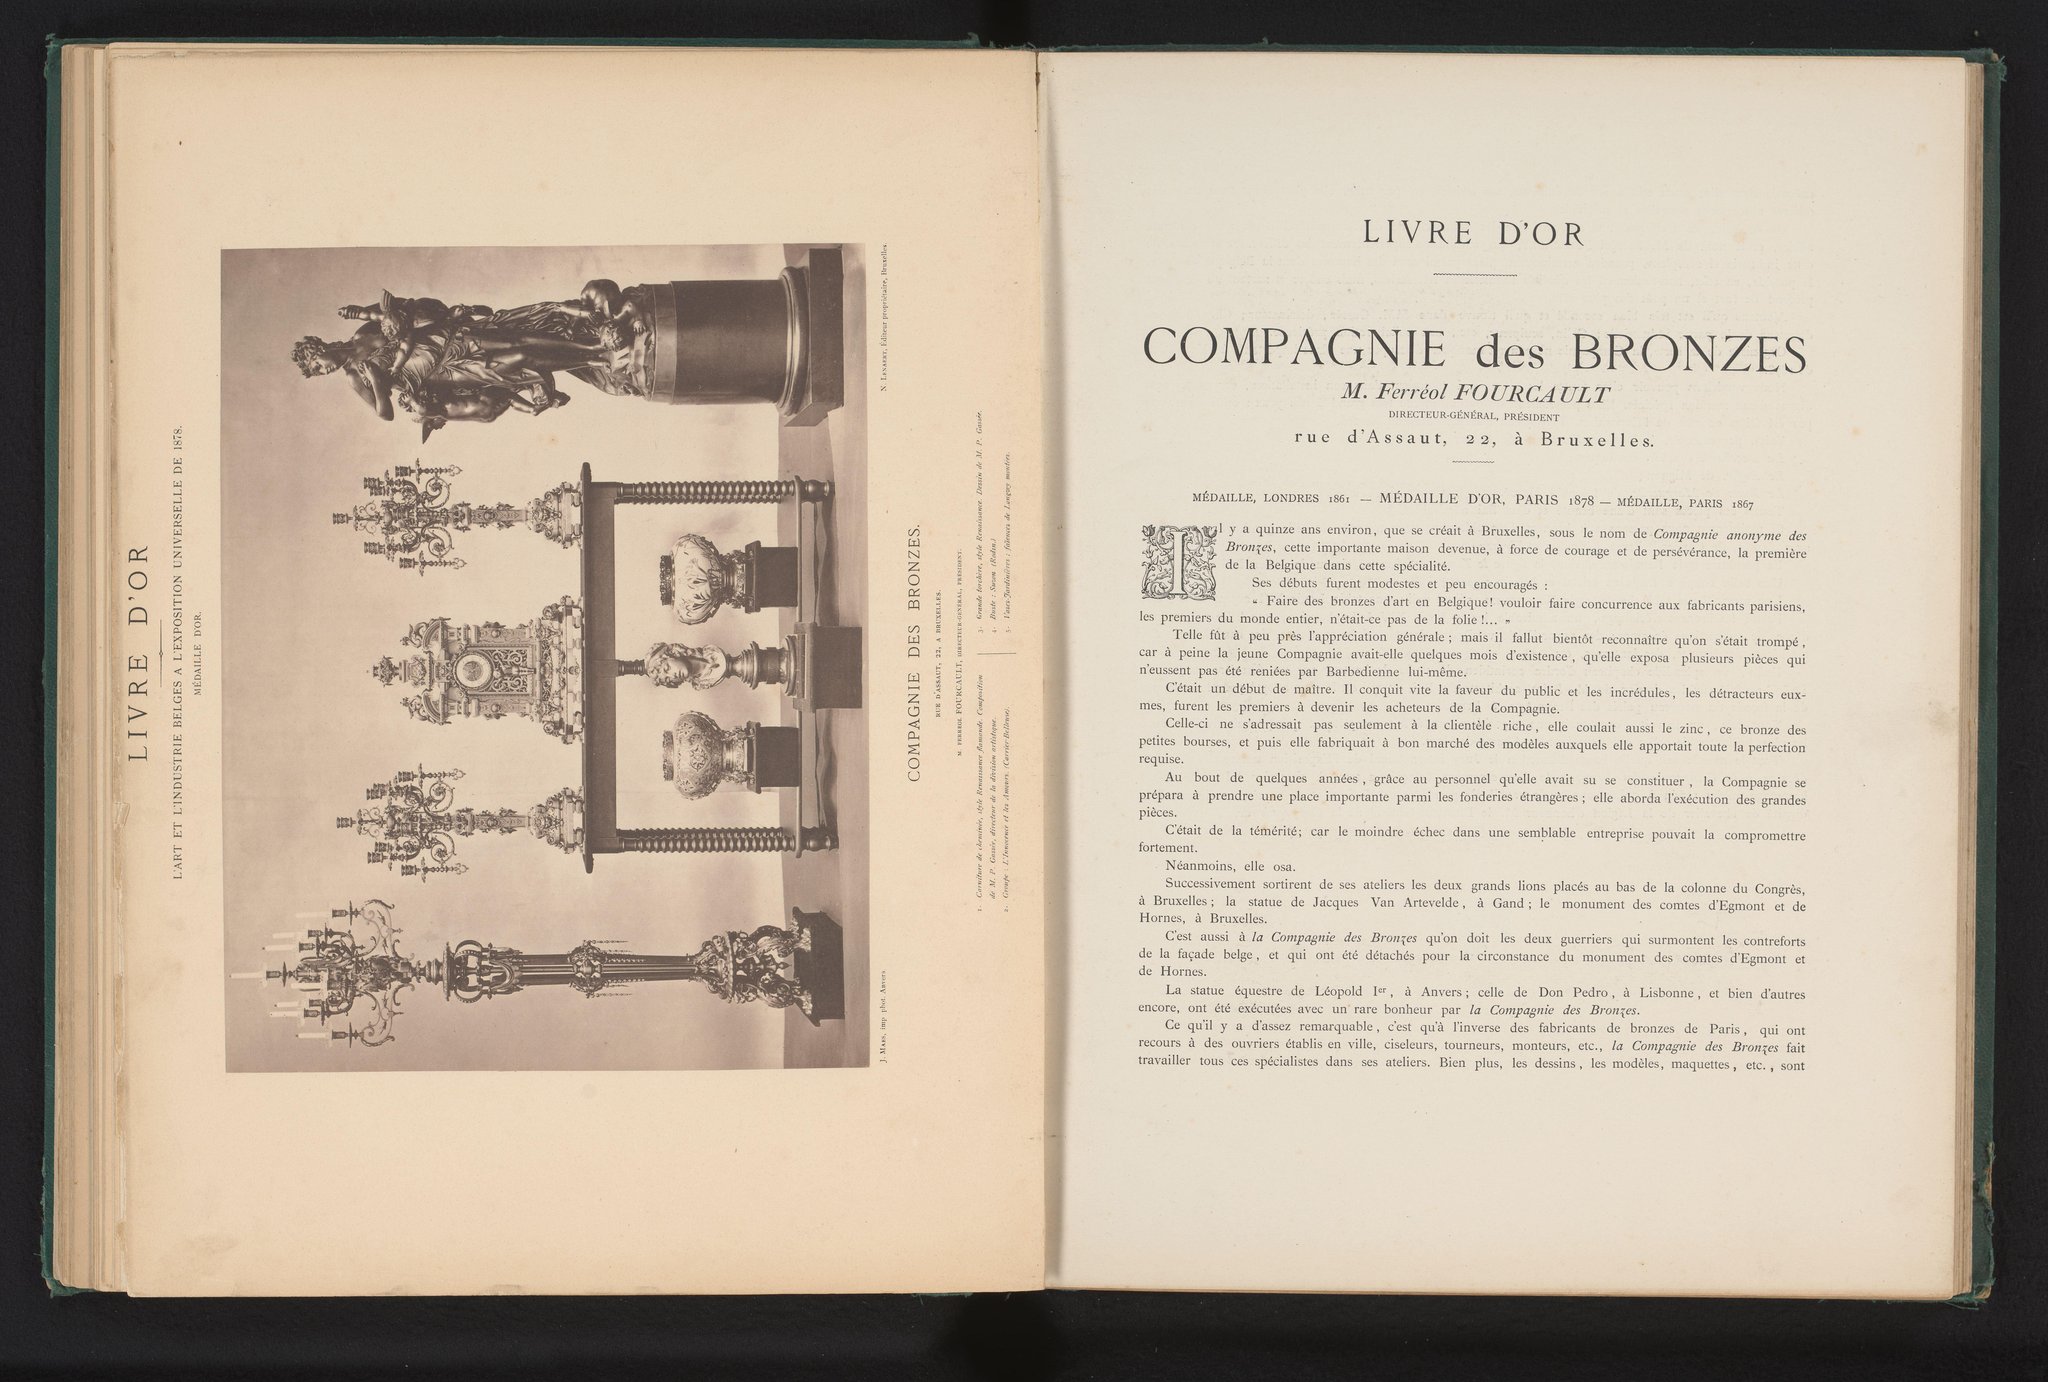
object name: page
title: Drie kandelaren, twee vazen, twee beelden en een klok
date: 1874-1879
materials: paper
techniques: photograph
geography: antwerp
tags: vase ~ ornament, clock, sculpture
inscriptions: inscription: ‘Livre d'or/ L'art et l'industrie Belges a l'exposition universelle de 1878.’